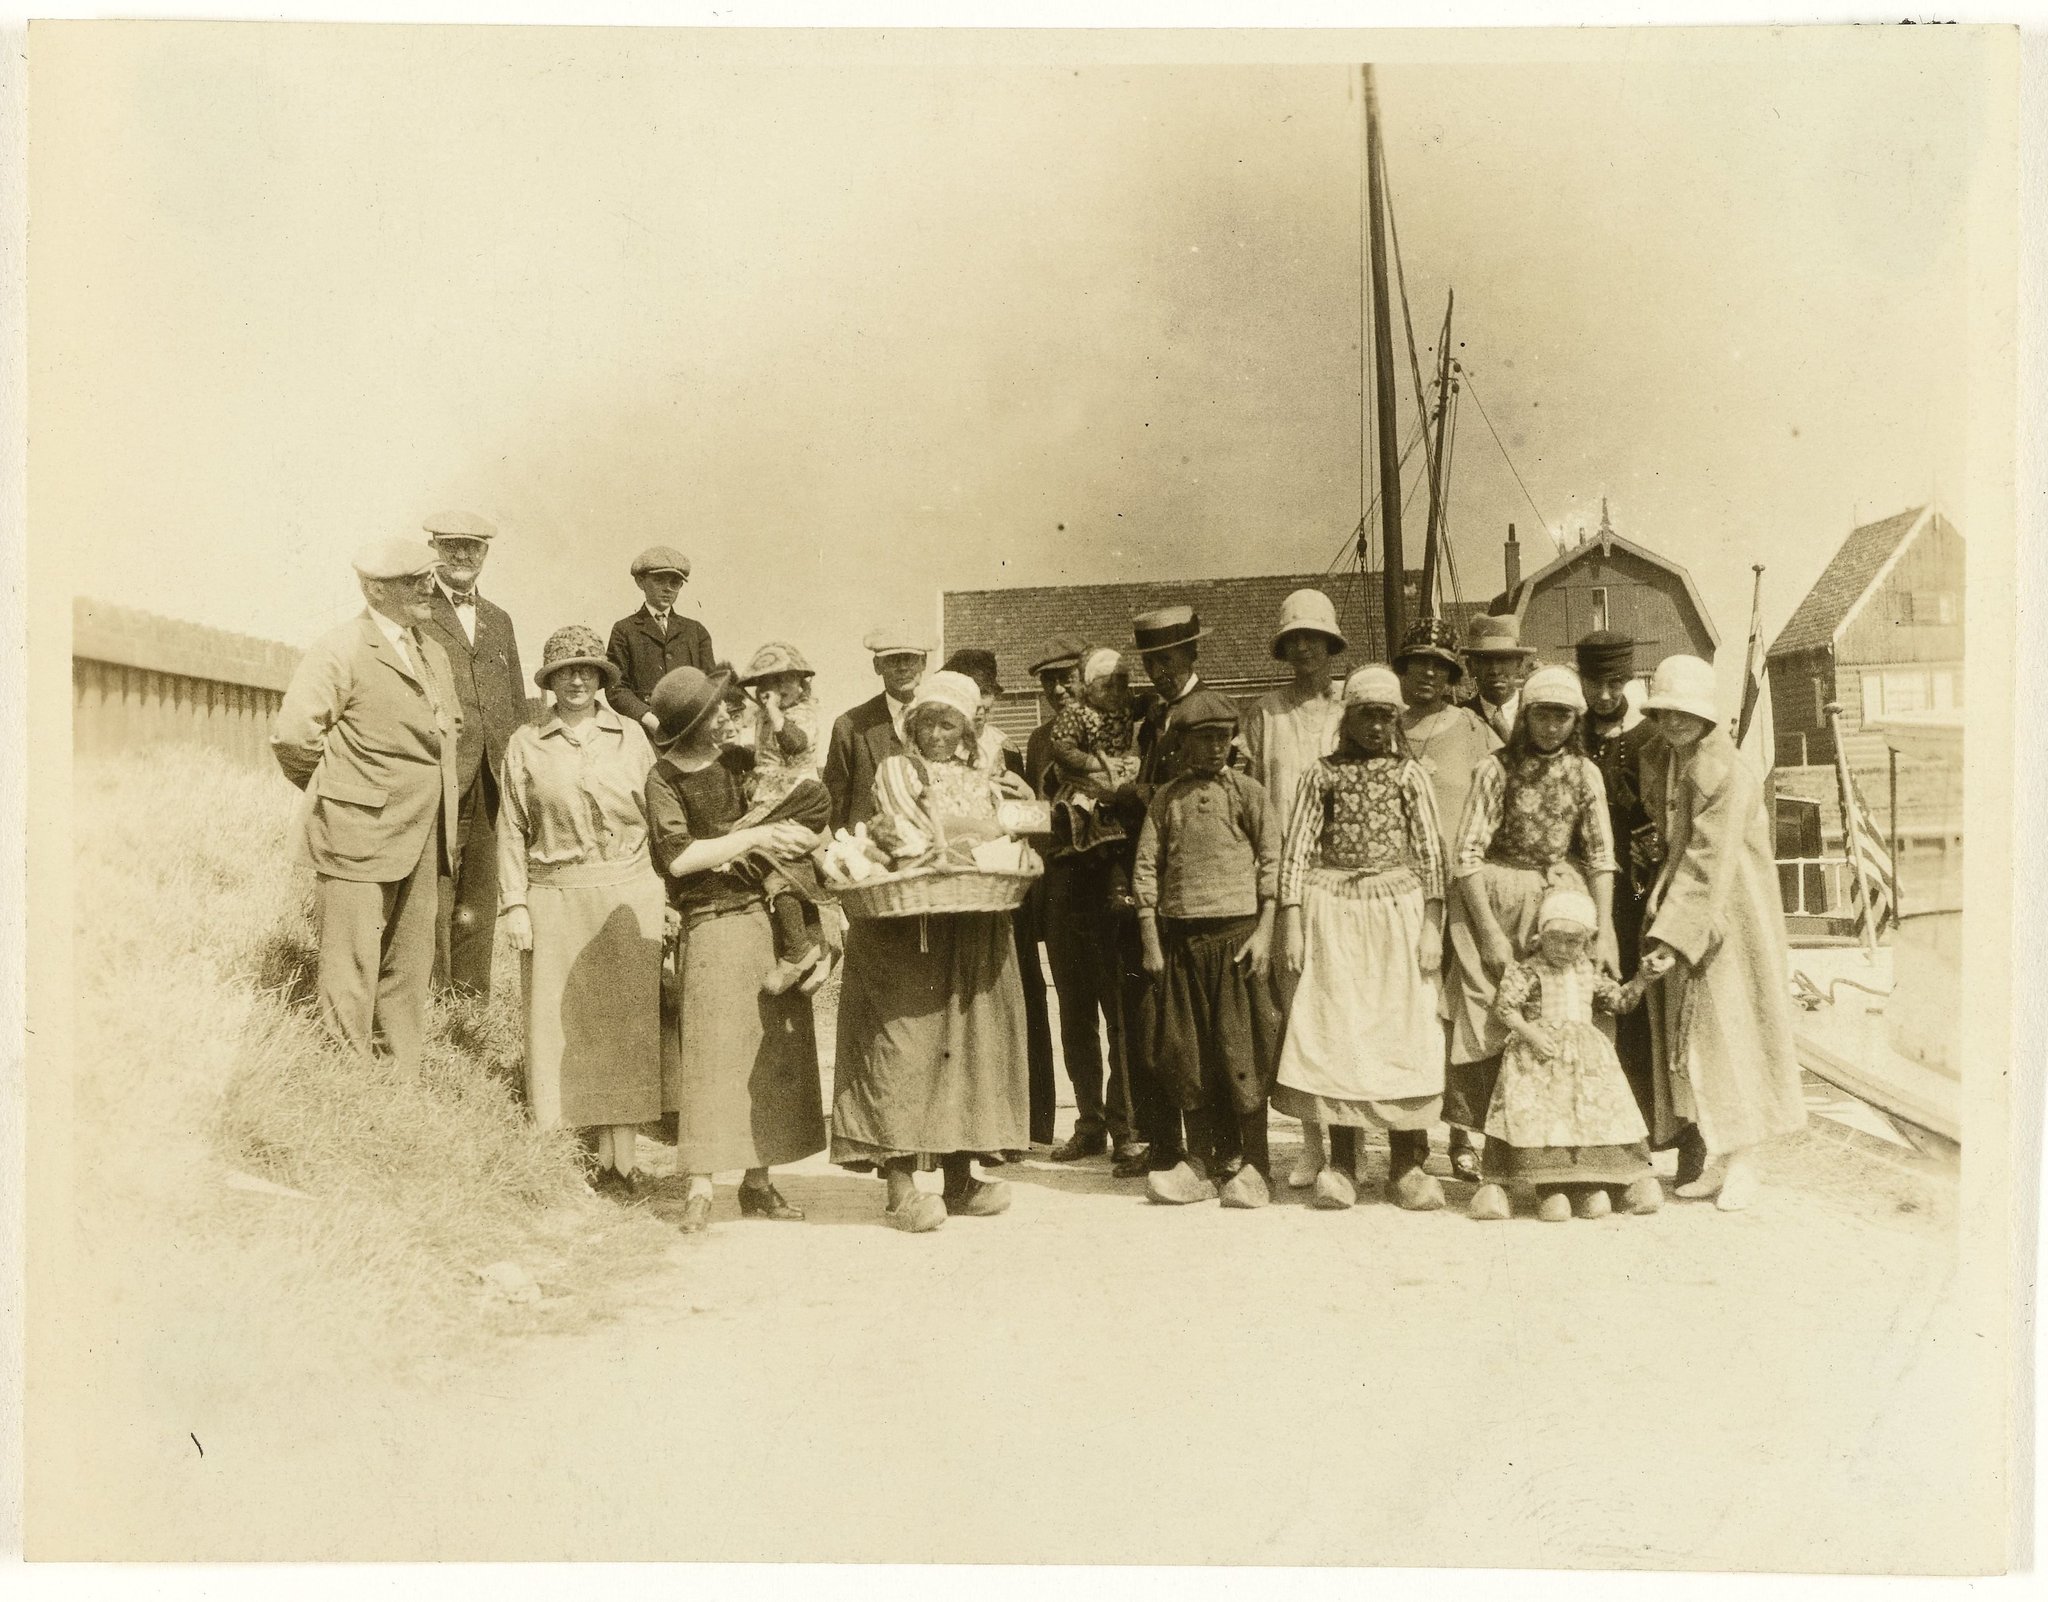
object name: photograph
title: Groep Amerikaanse toeristen in het gezelschap van vissersmeisjes, Volendam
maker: Anonymous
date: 1921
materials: paper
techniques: gelatin silver print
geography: volendam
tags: tourism